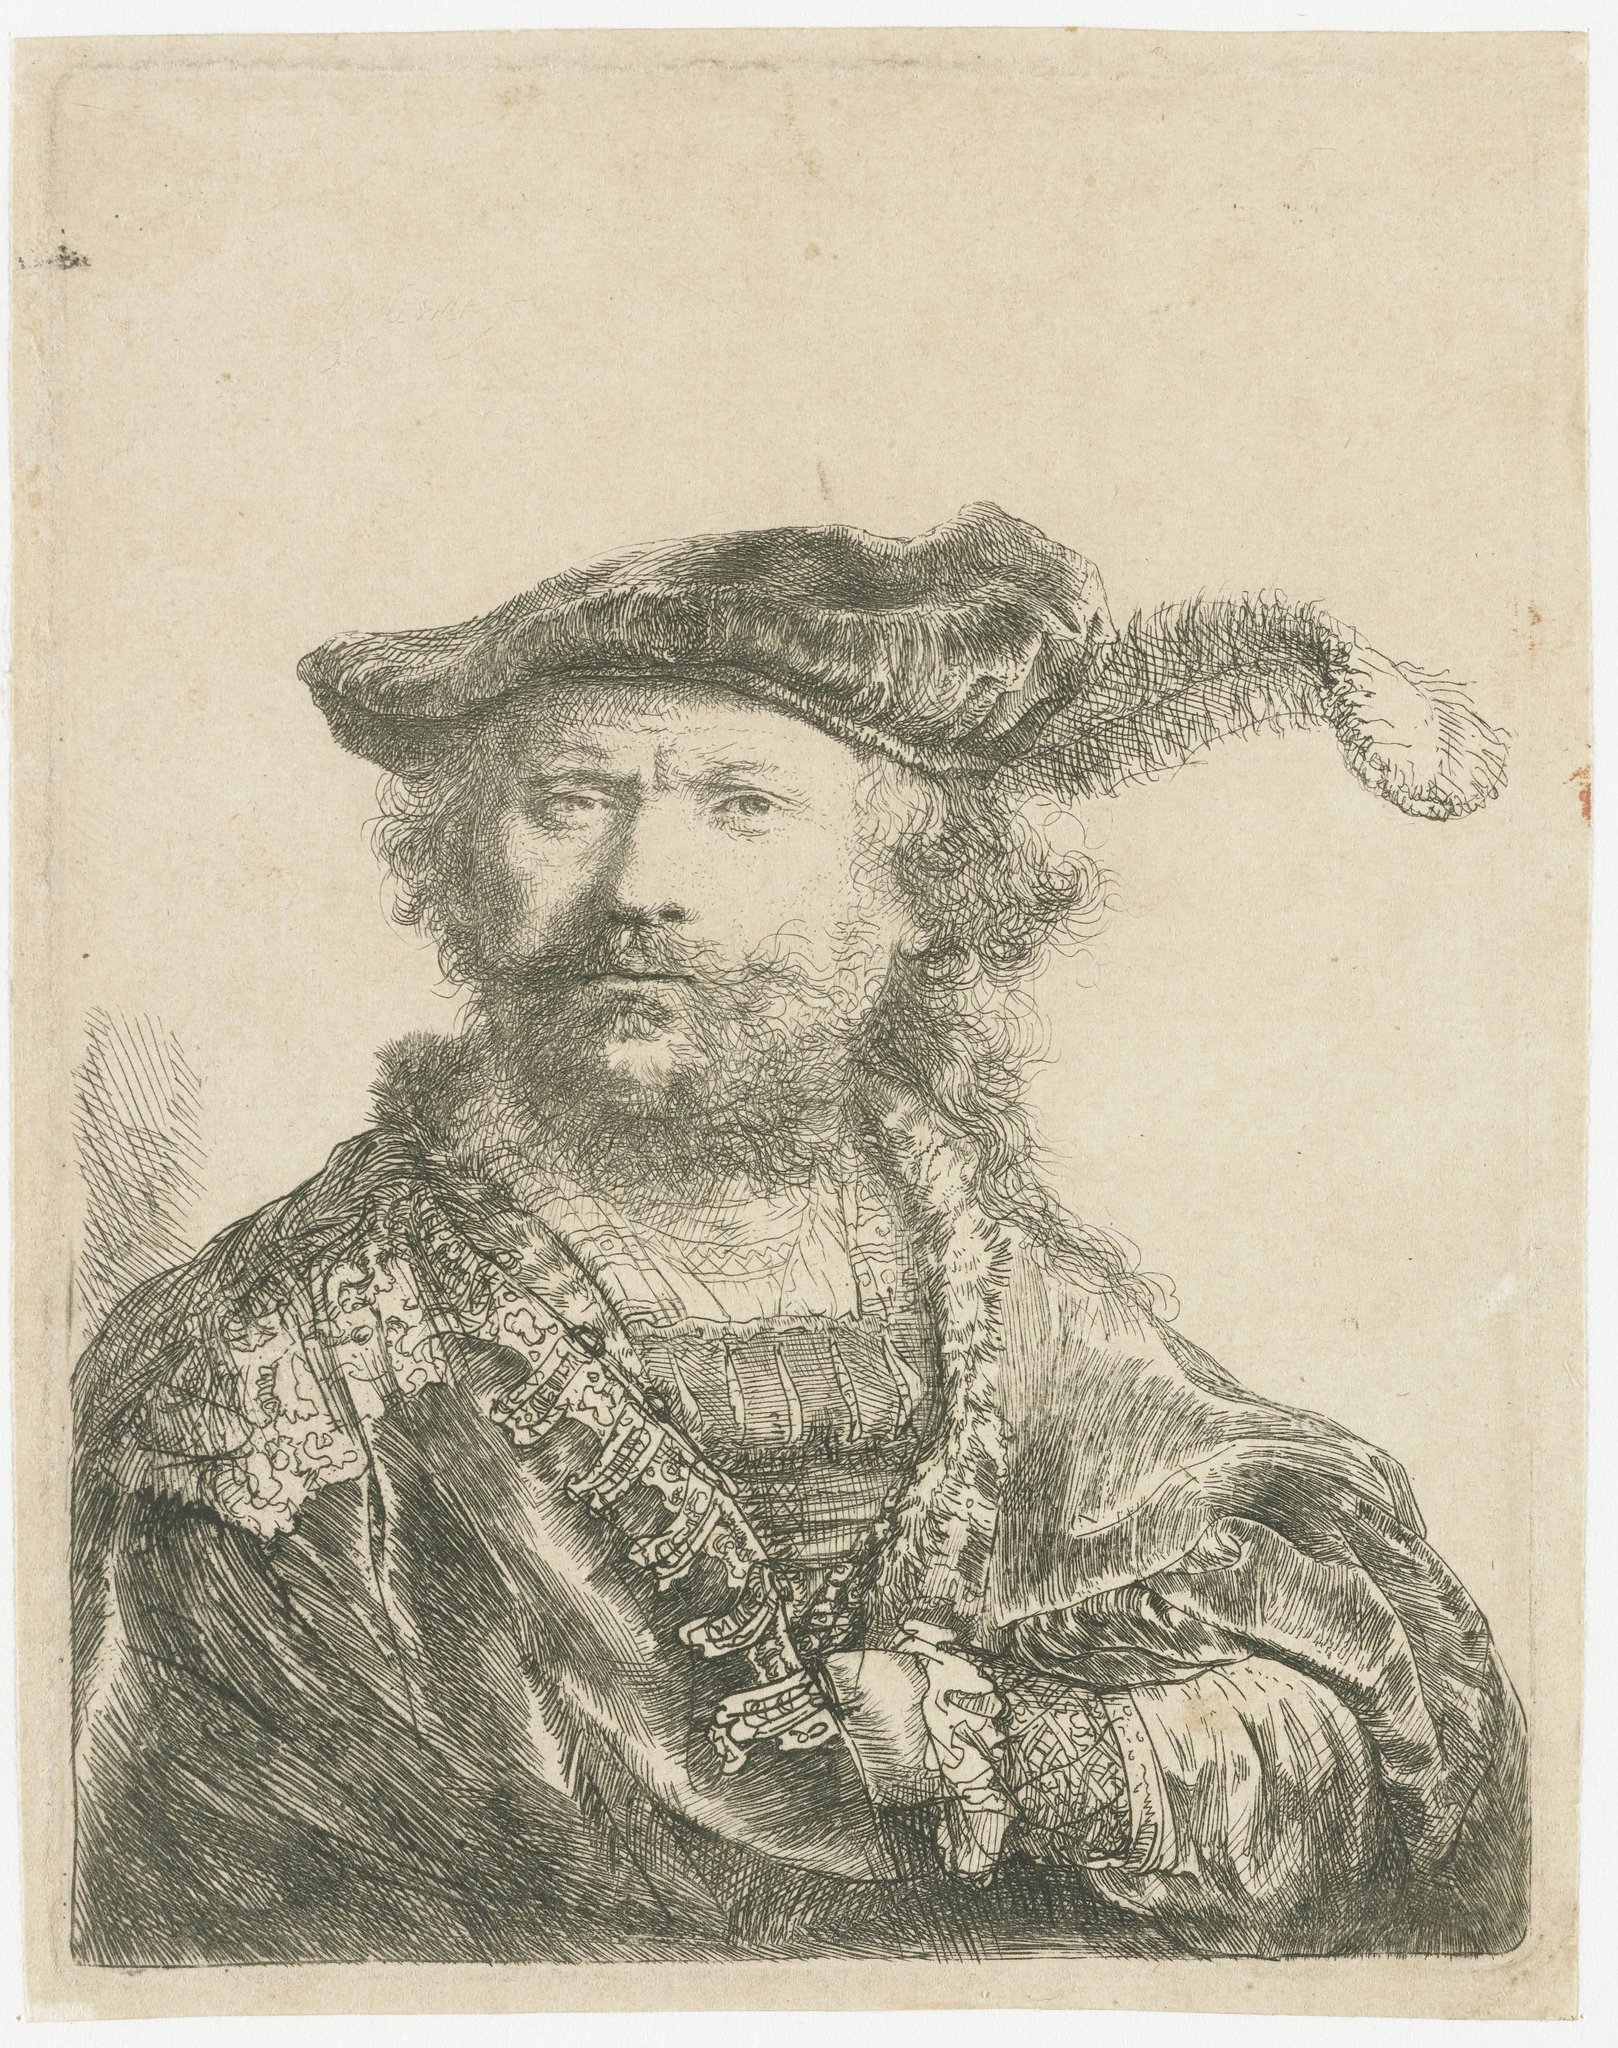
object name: print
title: Self-portrait in a velvet cap with plume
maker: rembrandt van rijn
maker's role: draughtsman, painter, print maker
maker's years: 1606-1669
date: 1638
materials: paper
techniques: drypoint, etching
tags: leiden, amsterdam, painter, print maker, rembrandt van rijn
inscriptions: collector's mark: Lugt 240